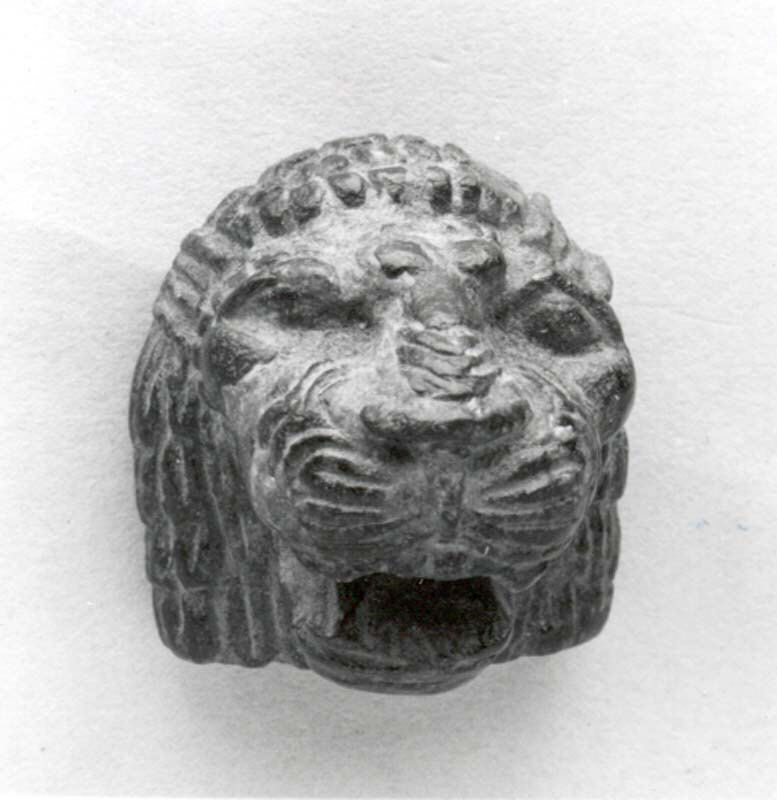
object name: bos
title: Boss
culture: neo-sumerian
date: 2100-2000 BCE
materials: stone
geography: mesopotamia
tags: lions